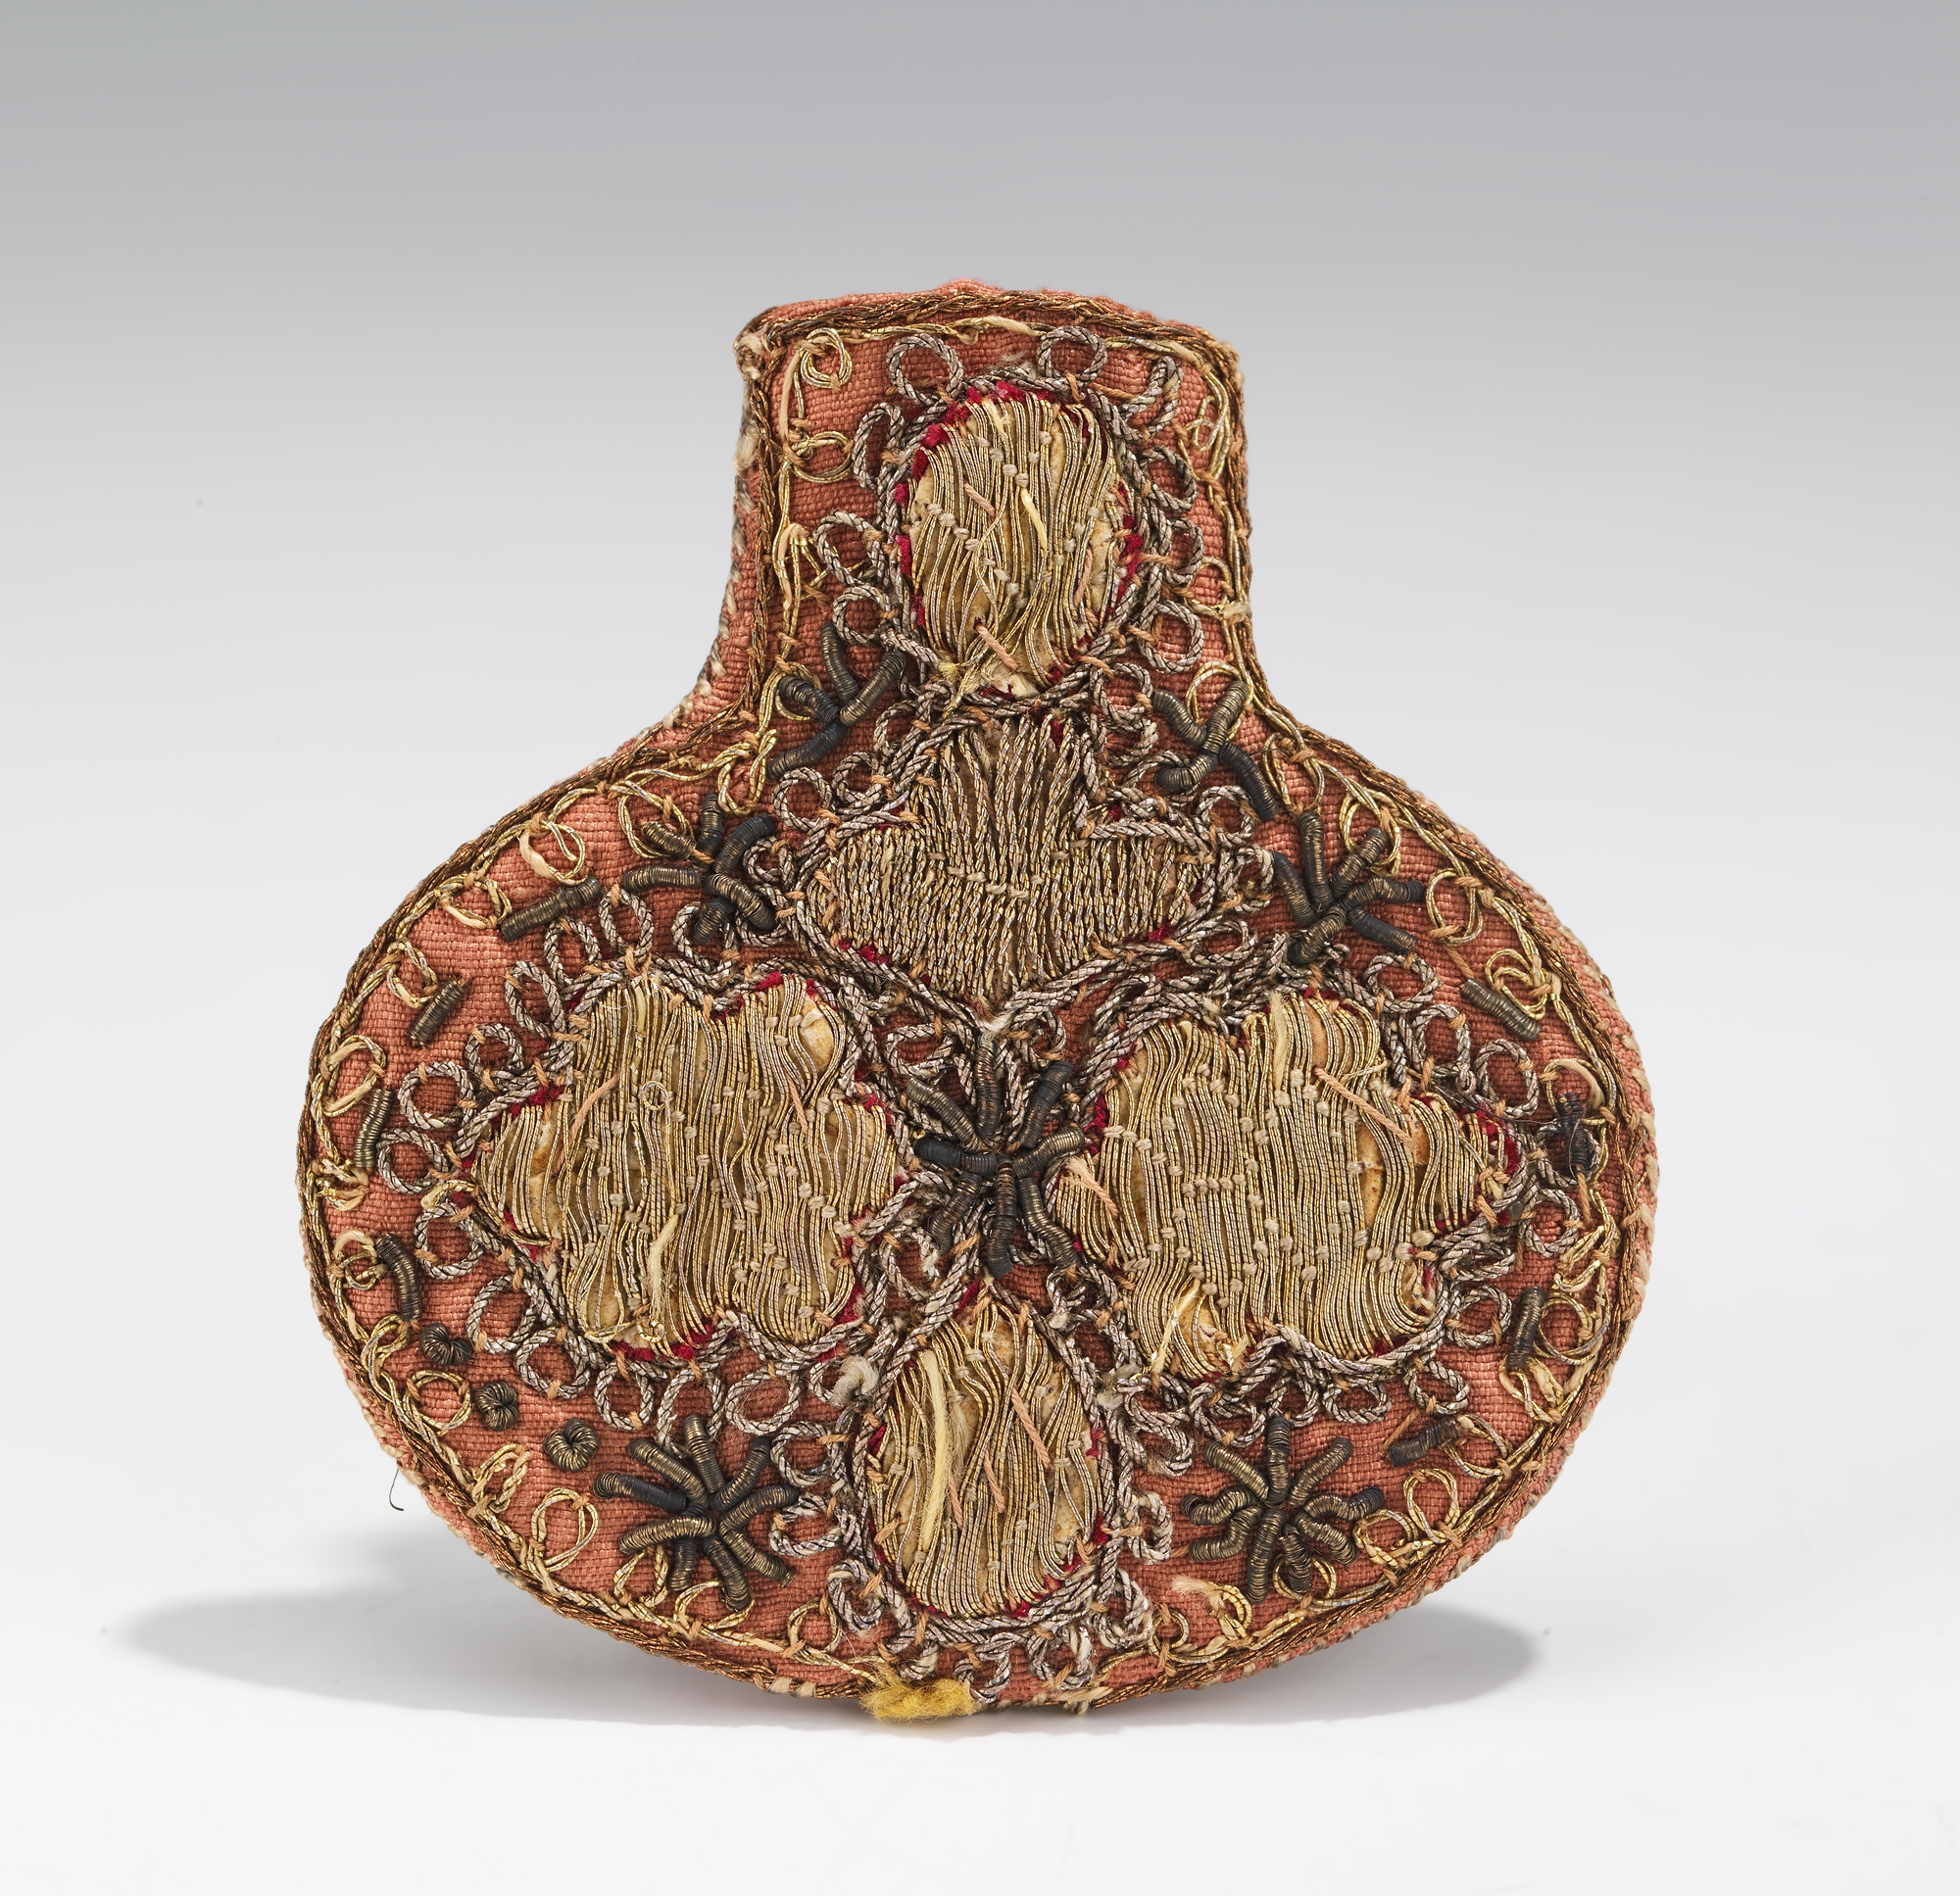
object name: case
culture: russian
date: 1767-1800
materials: metal, silk